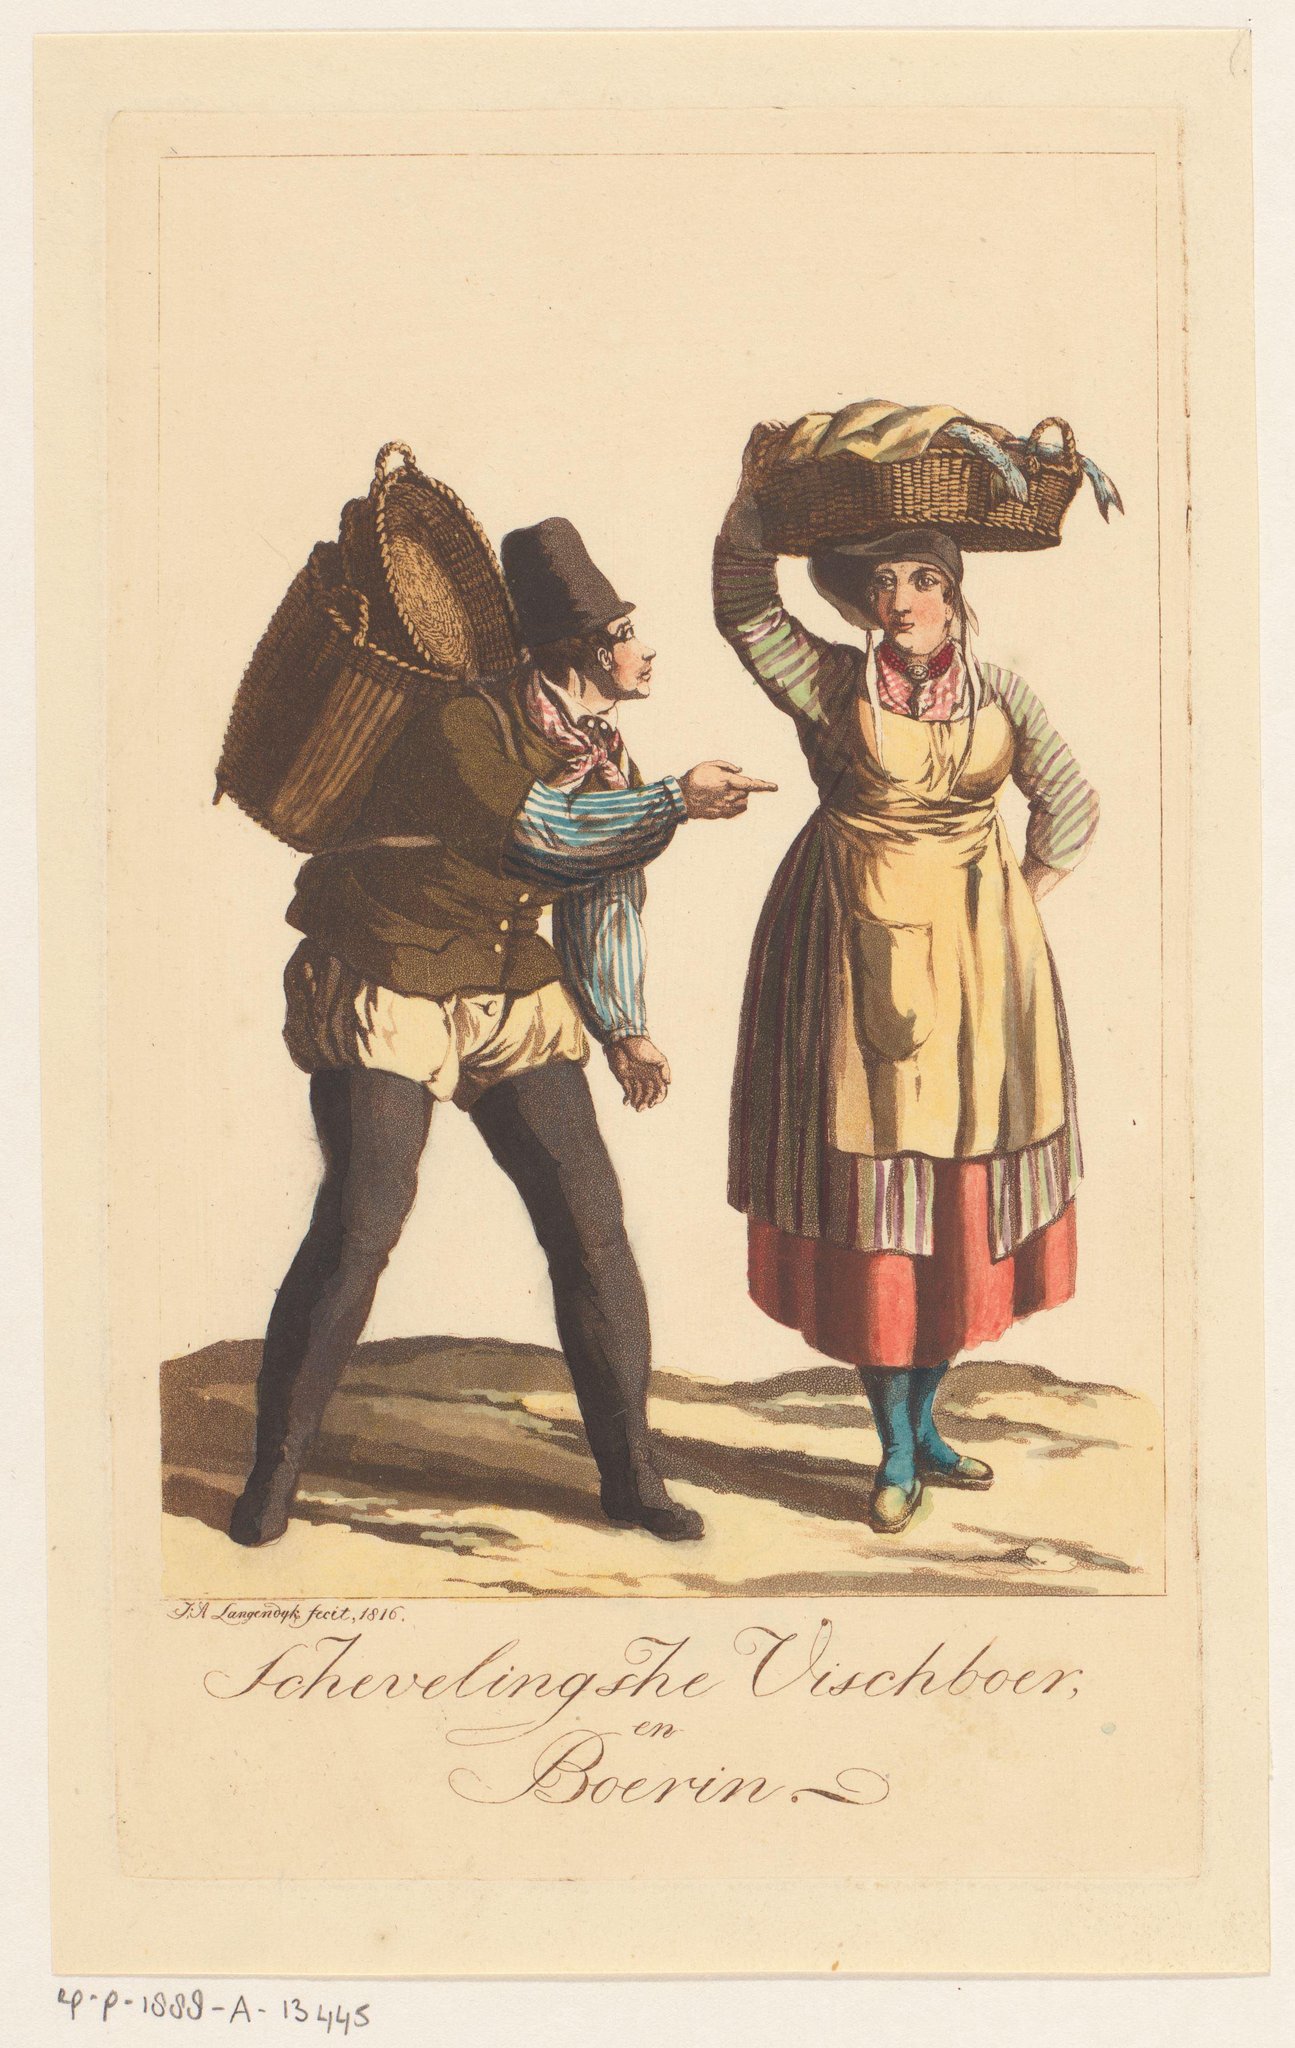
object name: print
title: Scheveningse visserstypen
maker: jan anthonie langendijk dzn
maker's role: draughtsman, print maker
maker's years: 1780-1818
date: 1816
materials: paper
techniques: color aquatint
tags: fishes, fisherman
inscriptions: collector's mark: Lugt 2228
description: Een visboer en visvrouw voeren een gesprek. De man links draagt een mand op zijn rug, de vrouw rechts draagt een mand met vis op haar hoofd.